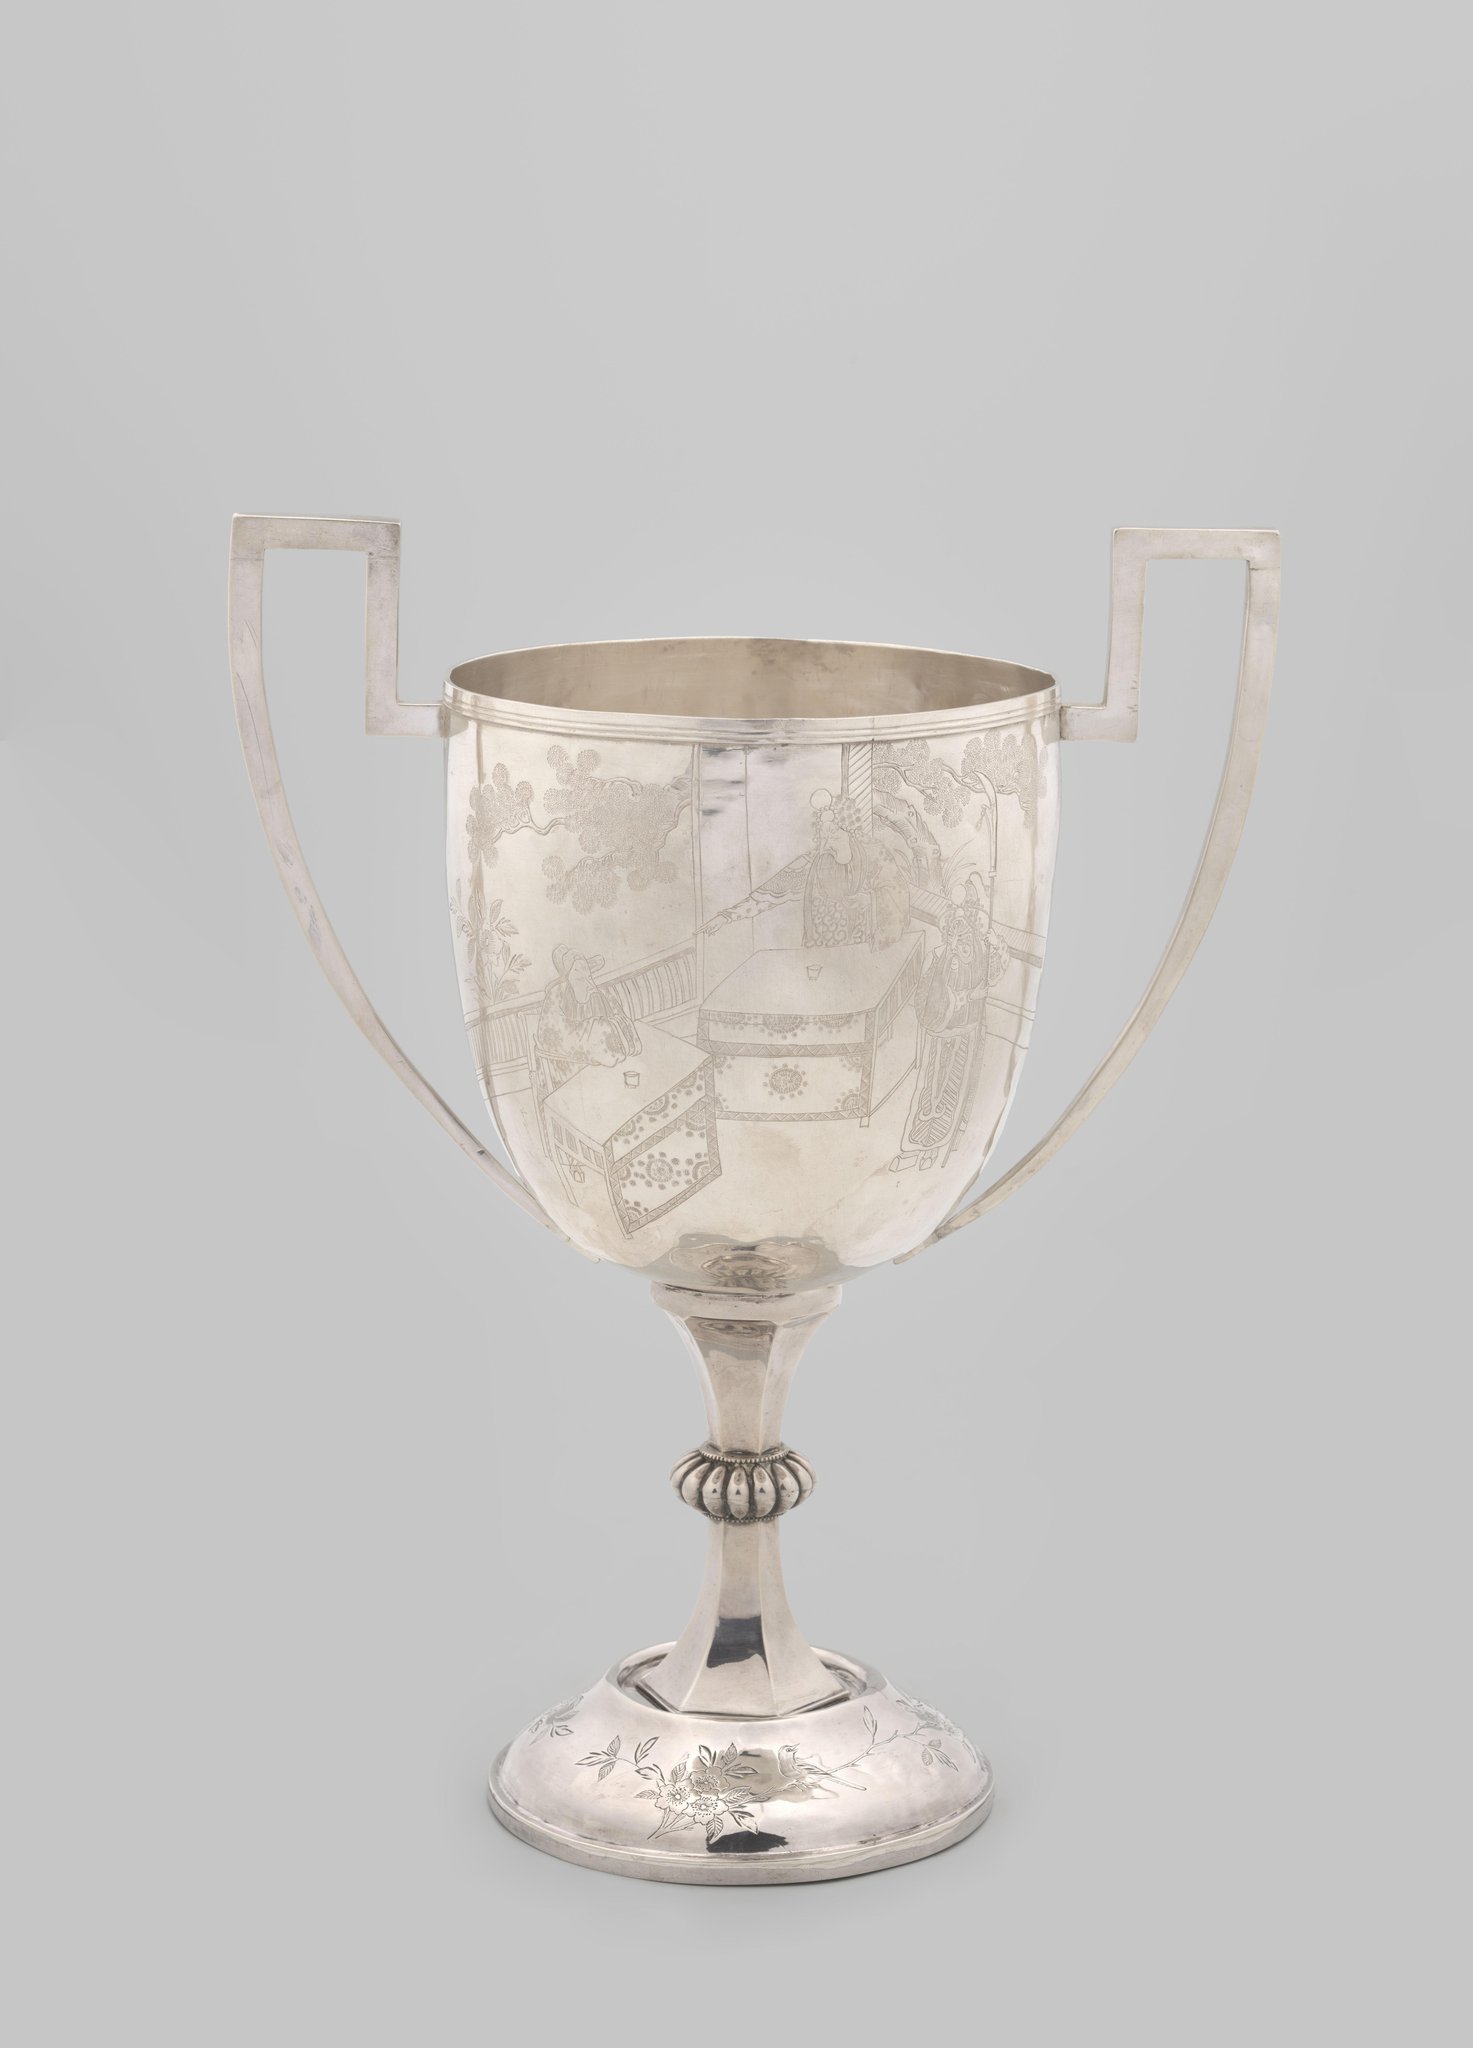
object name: cup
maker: bin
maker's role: silversmith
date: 1918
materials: silver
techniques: engraving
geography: beijing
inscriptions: inscription: ‘Voorstelling ontleend aan de roman 'De Drie Koninkrijken.’, inscription: ‘Zhang Xun bedankt voor zijn verblijf in de Nederlandse legatie in Peking 1917-1918’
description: In 1918, Chinese general Zhang Xun (1854-1923) presented this cup as a gift to the Dutch diplomatic envoy stationed in Peking. He had sought refuge there in 1917, after a failed attempt to reinstate the empire through military means. On one side of the cup is an engraved inscription expressing his gratitude for the Netherland’s help, and on the other side is a Chinese scene. While the decoration reflects Chinese tradition, the cup’s shape adheres to a Western aesthetic.